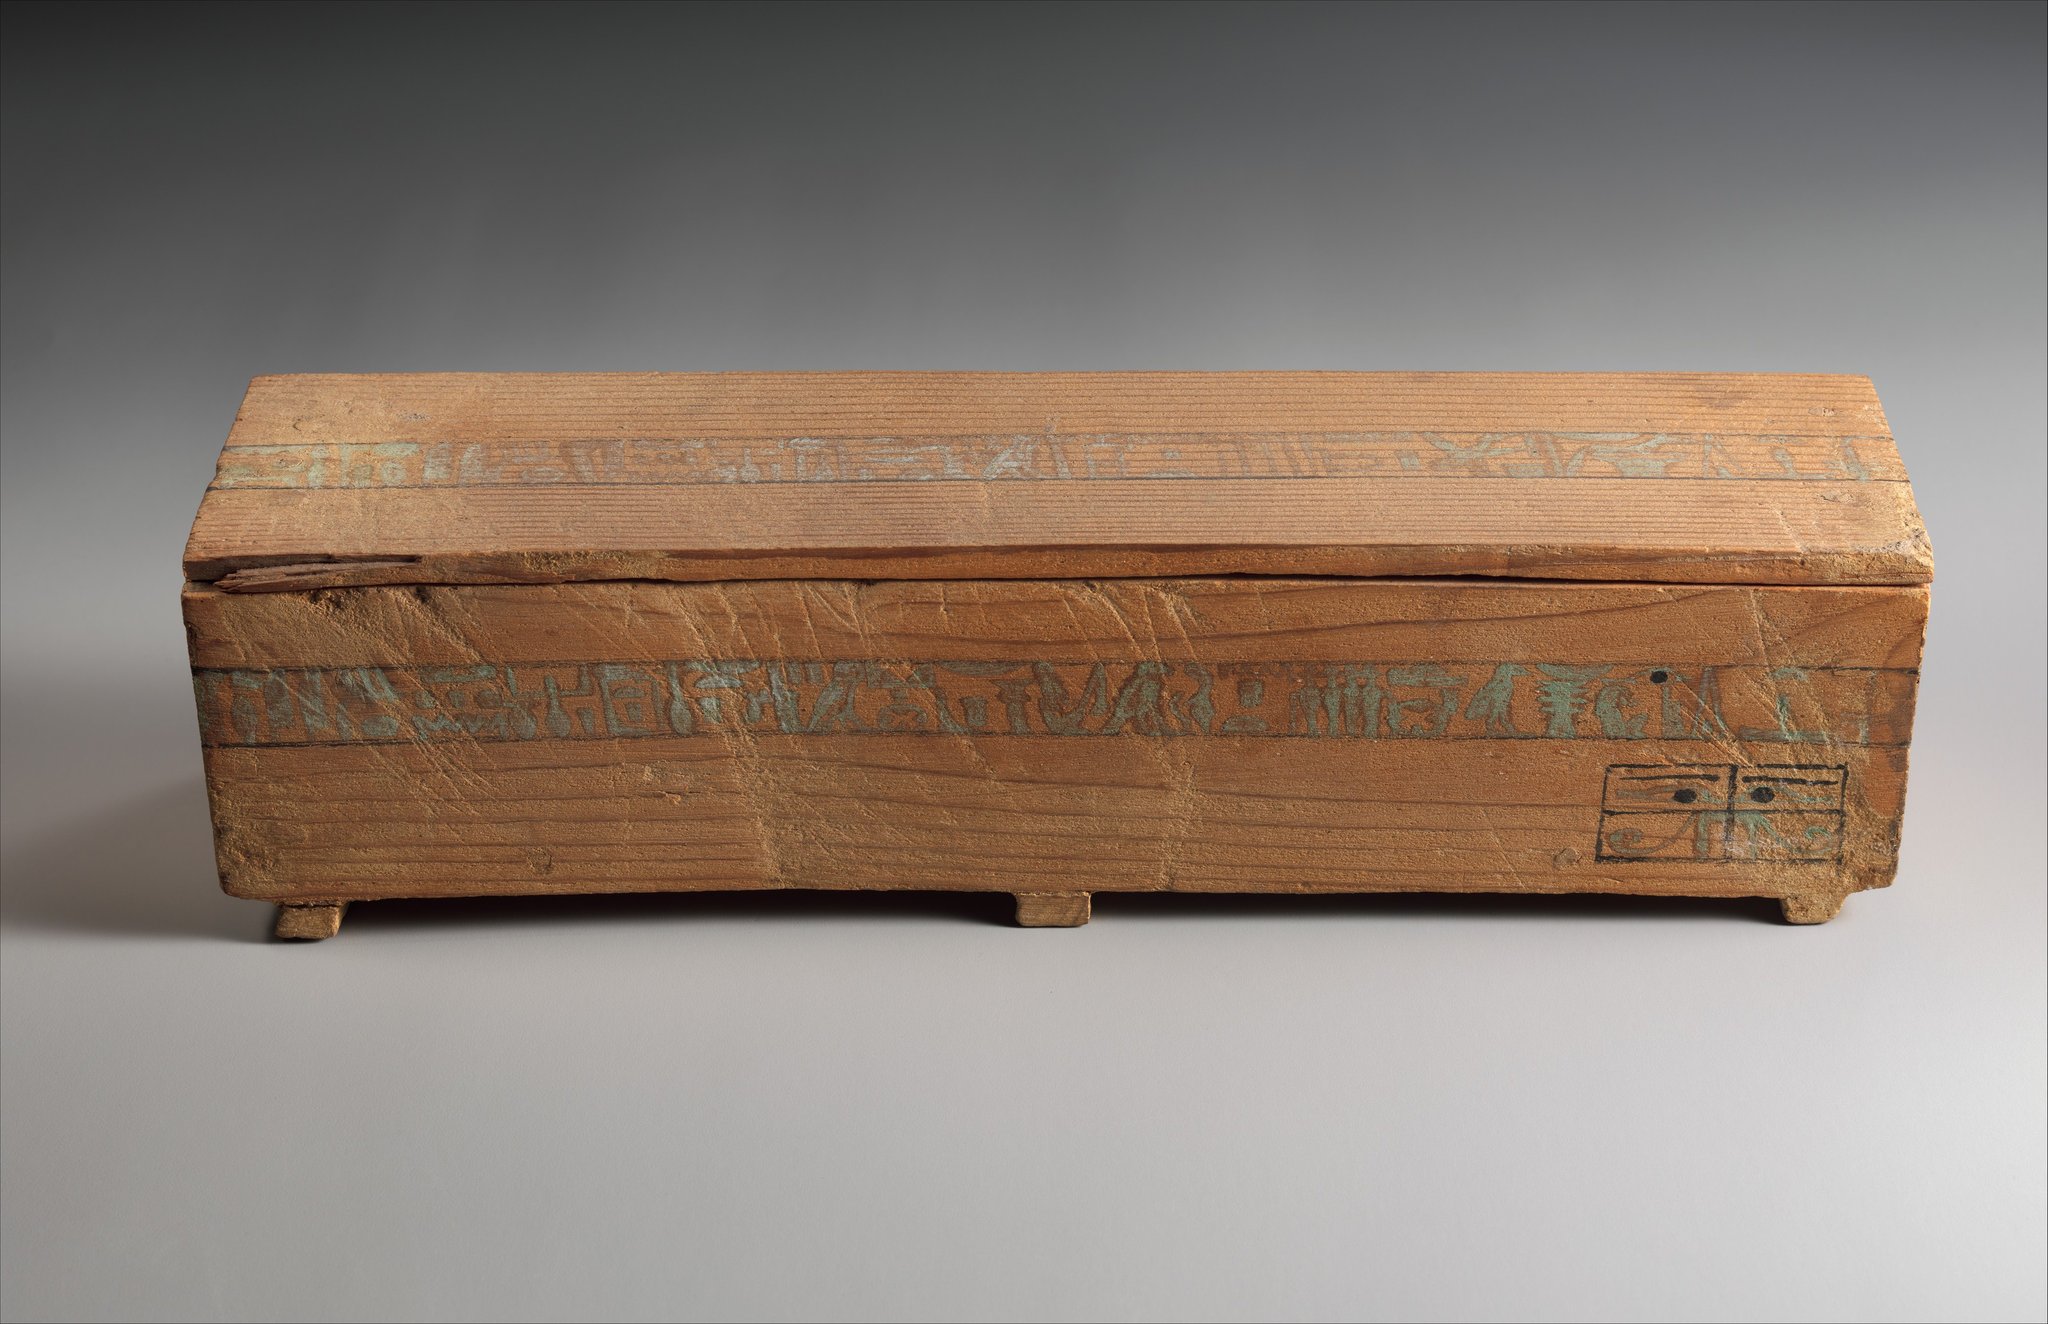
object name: coffin, miniature, saiah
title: Miniature coffin of Saiah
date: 2051-1981 BCE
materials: wood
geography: egypt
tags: hieroglyphs,coffins